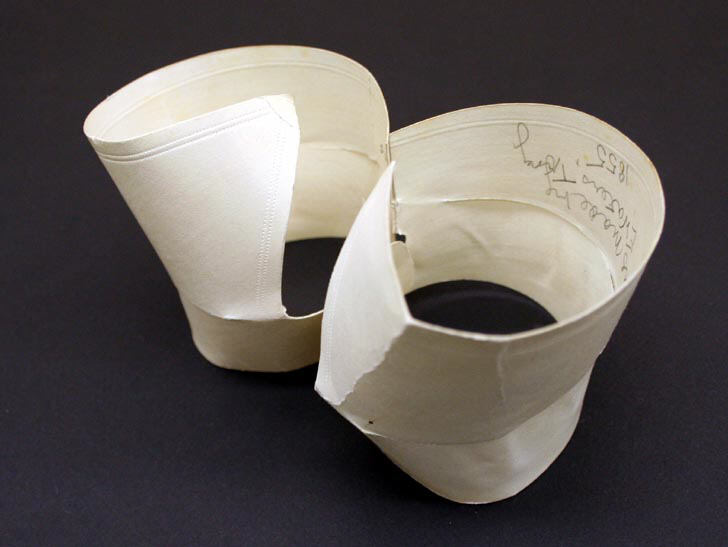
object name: collar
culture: american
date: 1855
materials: paper